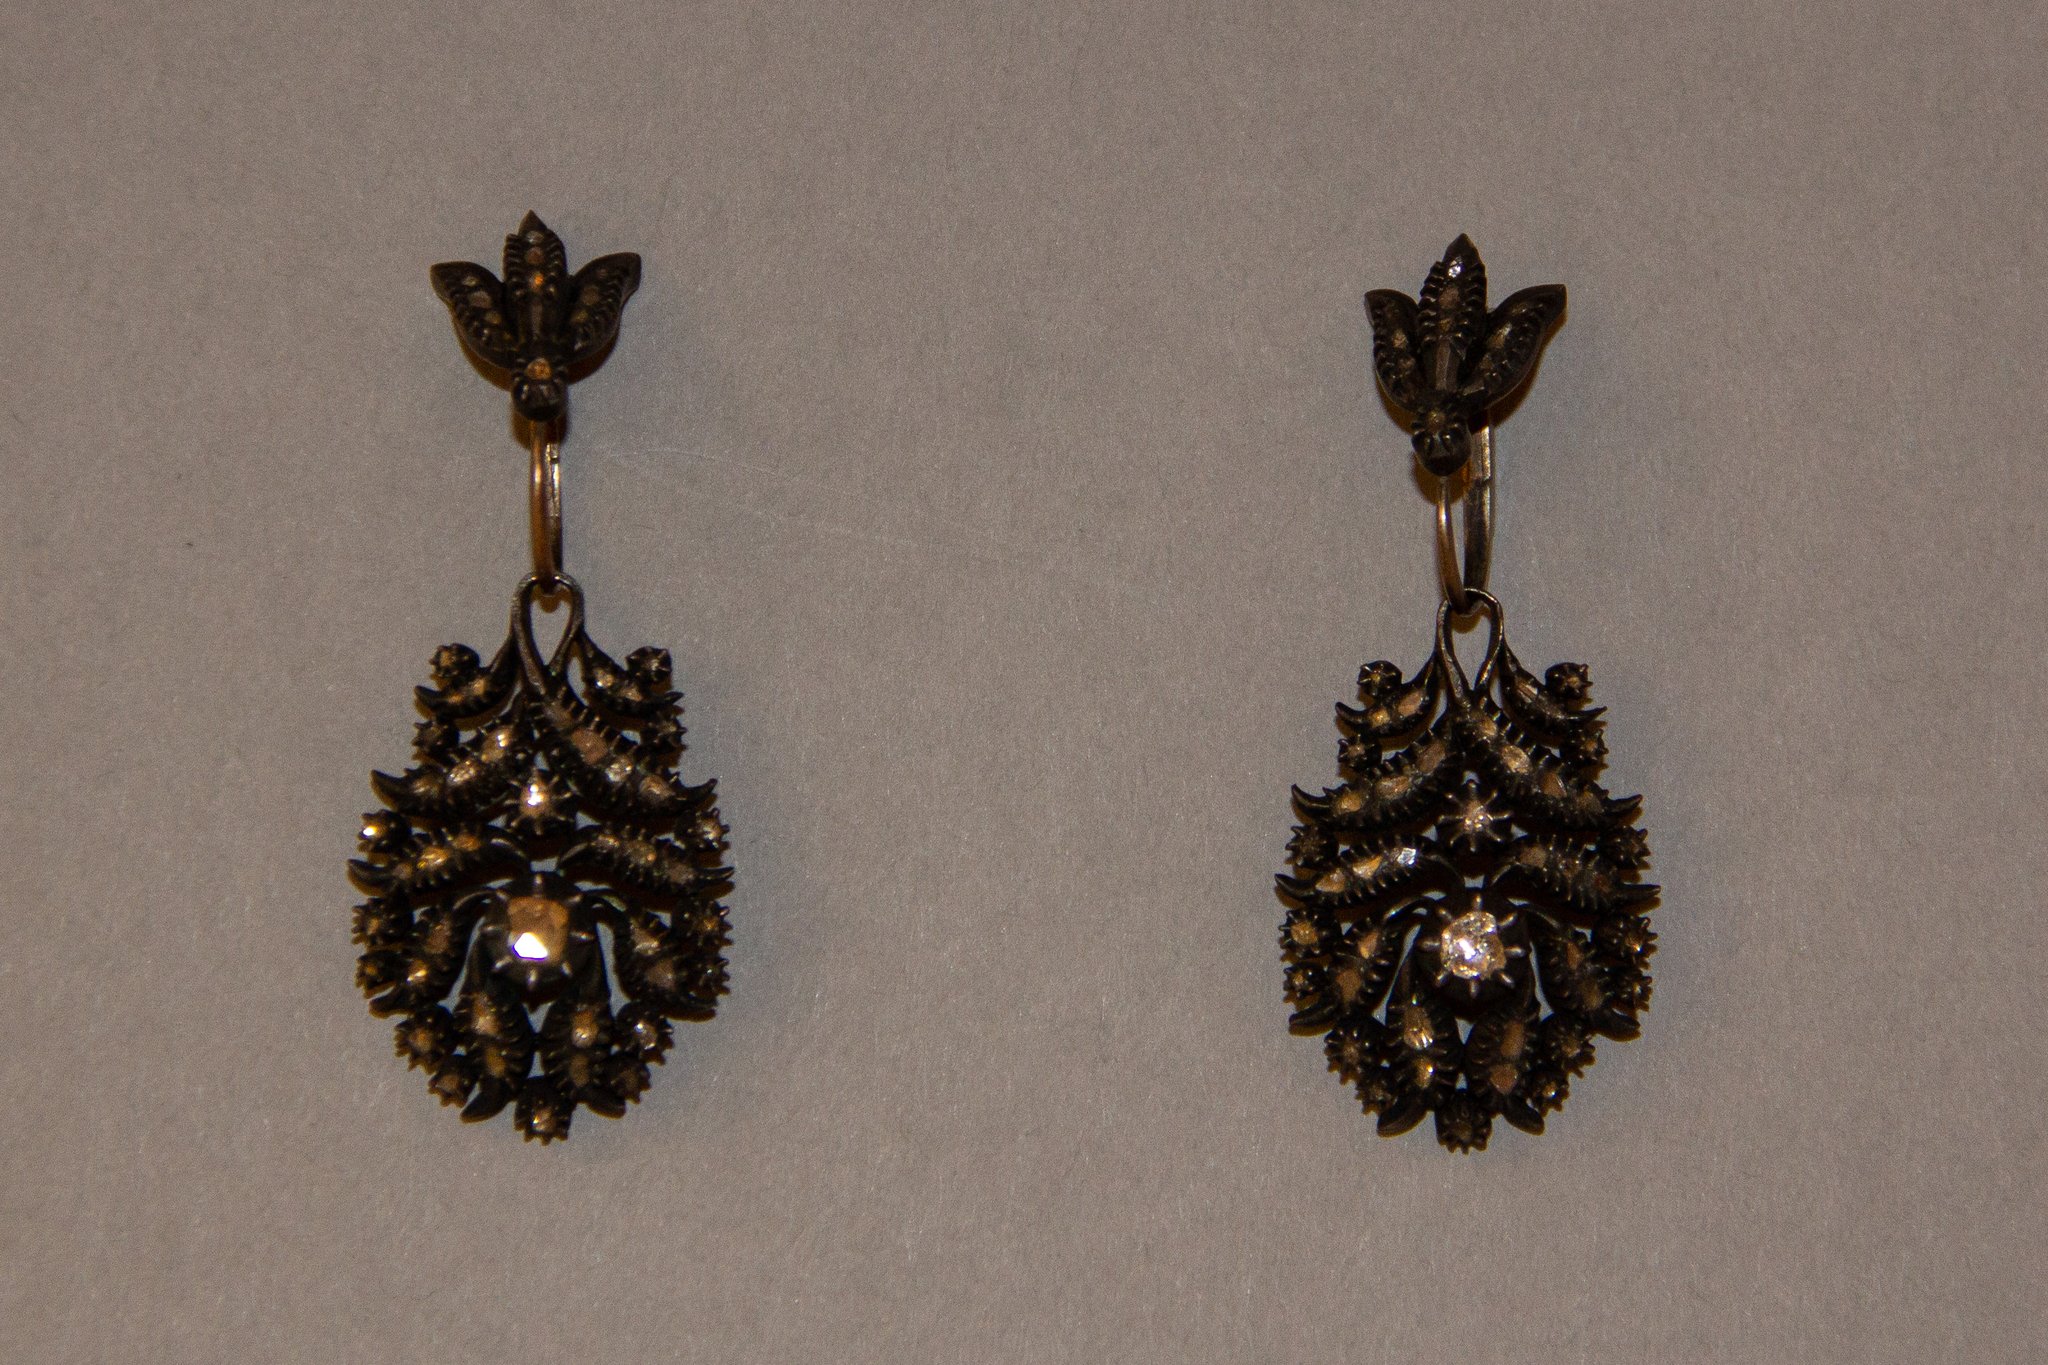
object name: earring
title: Earring, One of a Pair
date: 1801-1900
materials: diamond, silver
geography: north africa